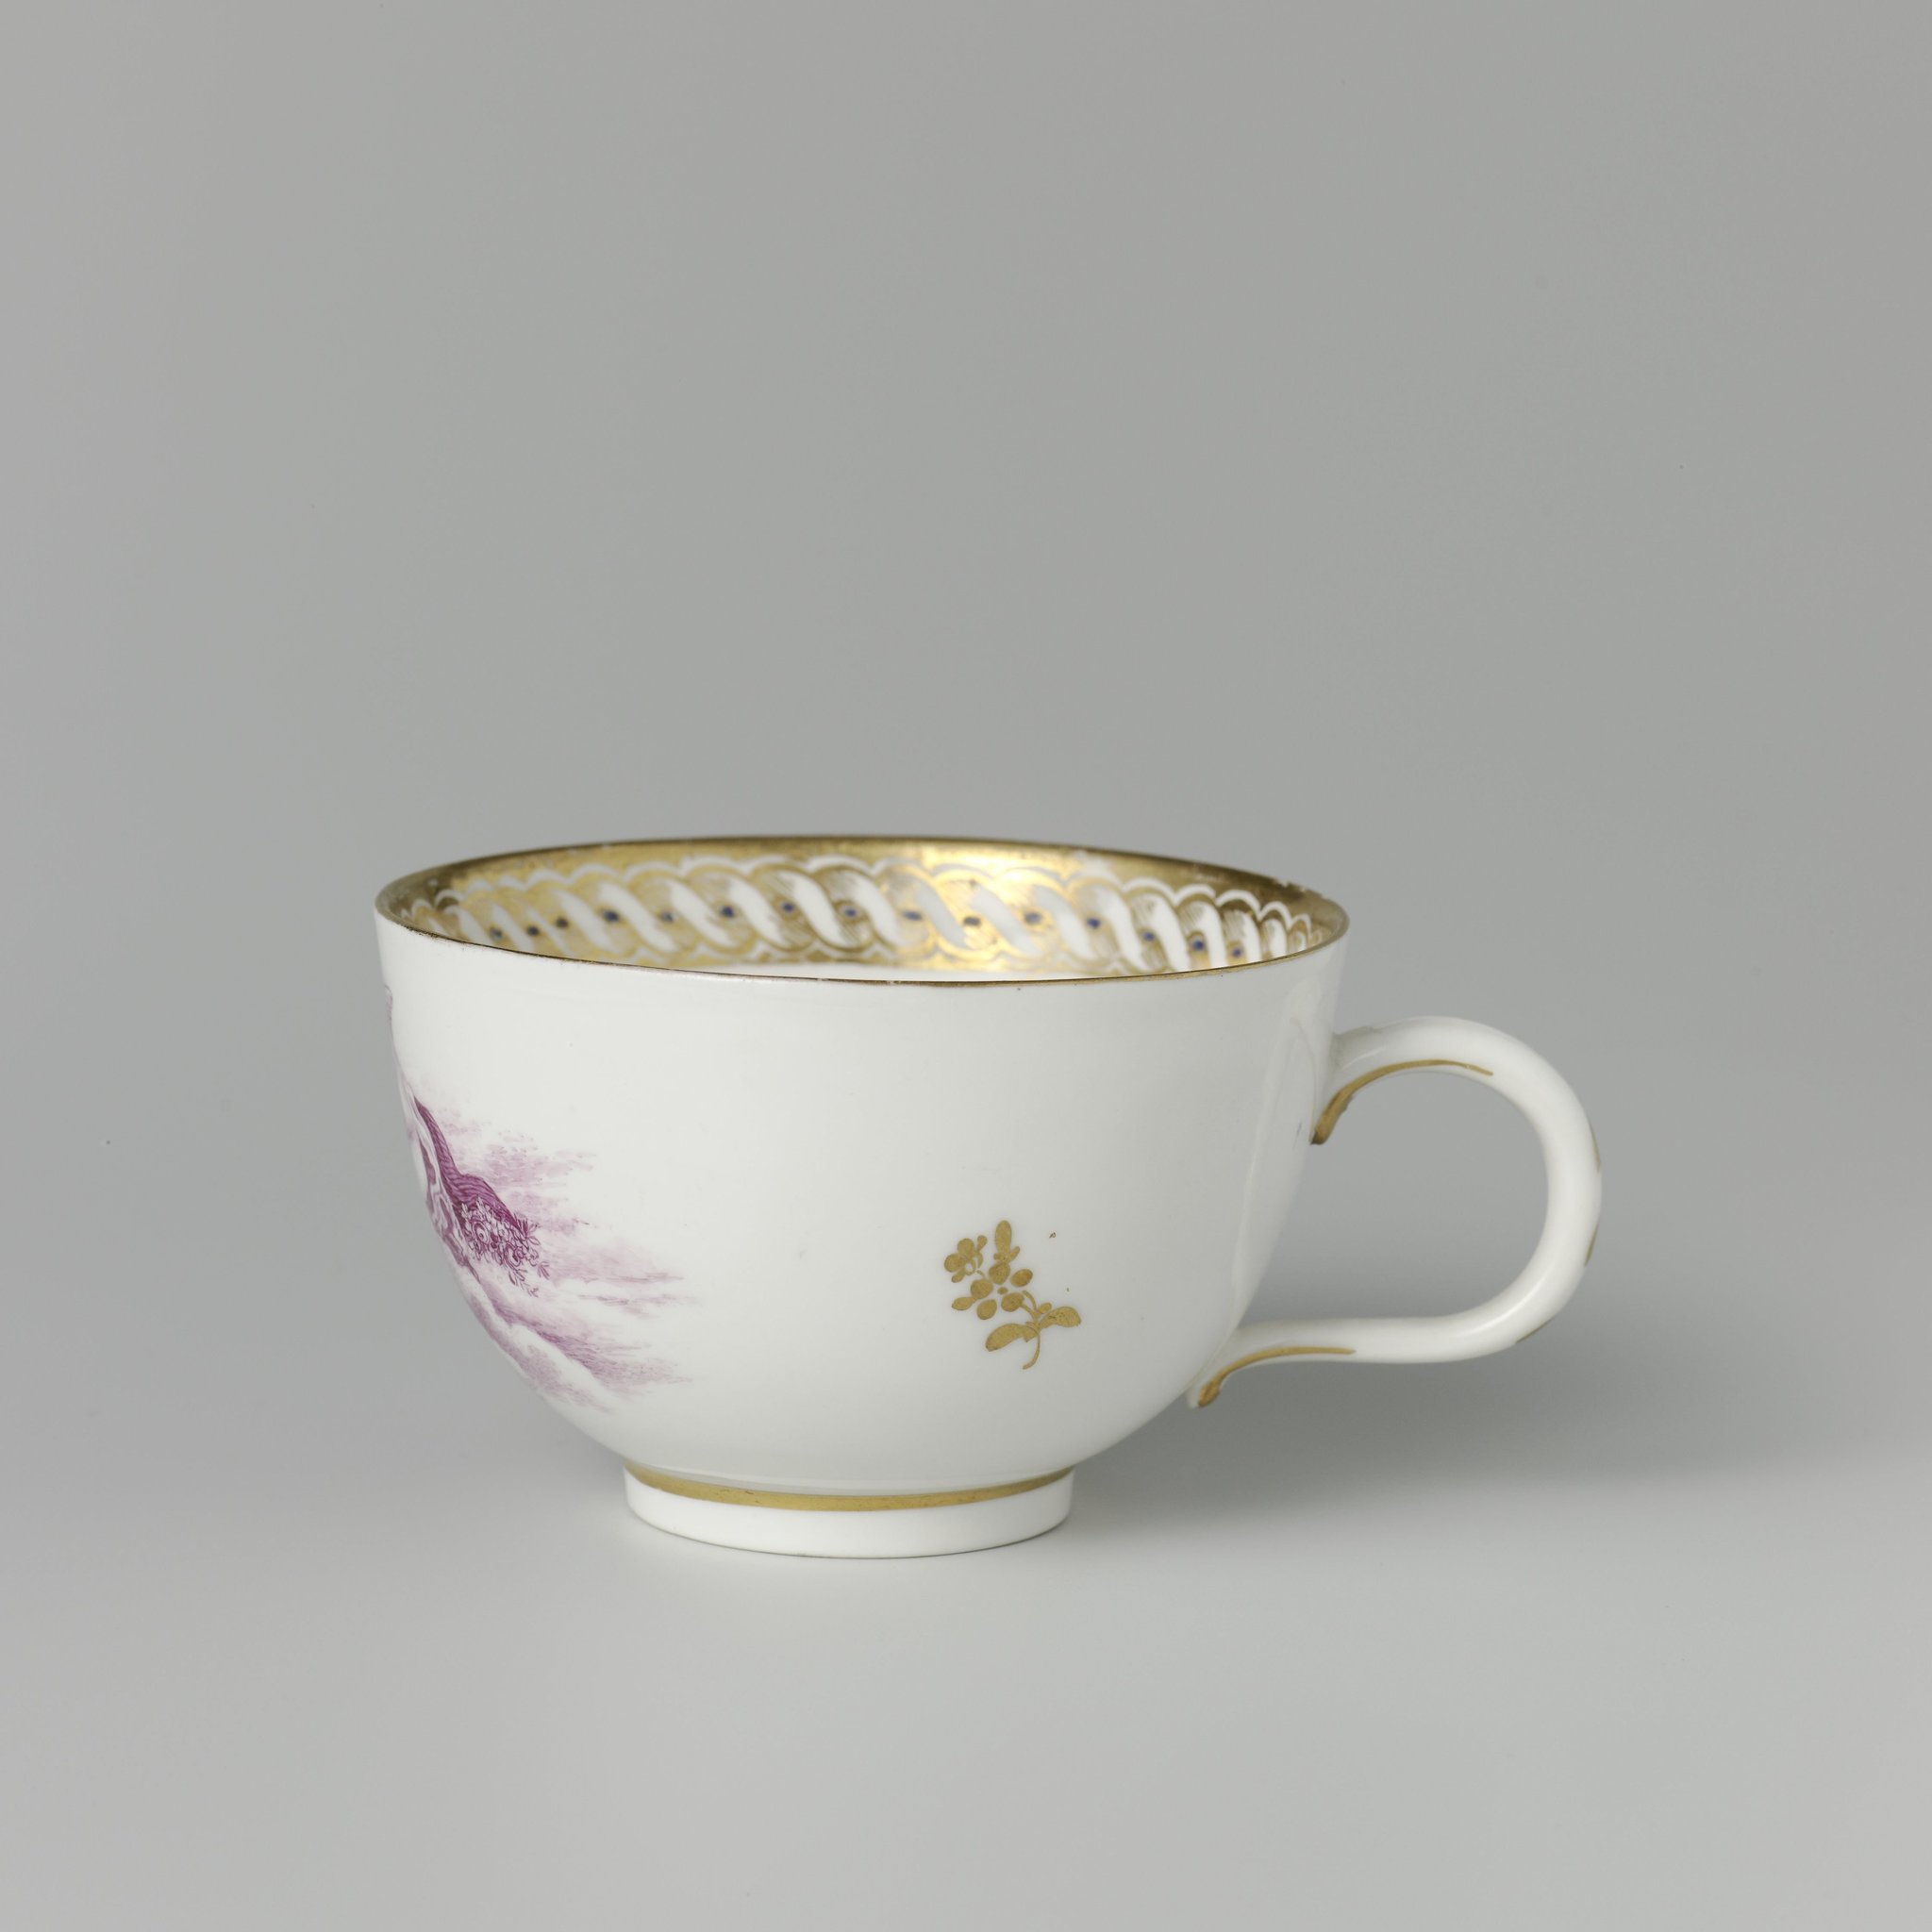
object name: cup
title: Cup with putti on clouds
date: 1785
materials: glaze, gold, paint, porcelain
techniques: firing, forming, gilding, turning, vitrification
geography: the hague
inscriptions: mark: ‘ooievaar’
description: Kop (theekop) van porselein met een C-vormig oor, beschilderd op het glazuur in roze (camaïeu) en goud. Op de buitenwand twee putti met bloemen op een wolk. Om de voorstelling strooibloemen in goud. De binnenrand met een gedraaide band, waaraan guirlandes en bloemtakken hangen. Gouden lijn op de voet en gouden rand. Gemerkt op de onderzijde met de ooievaar.